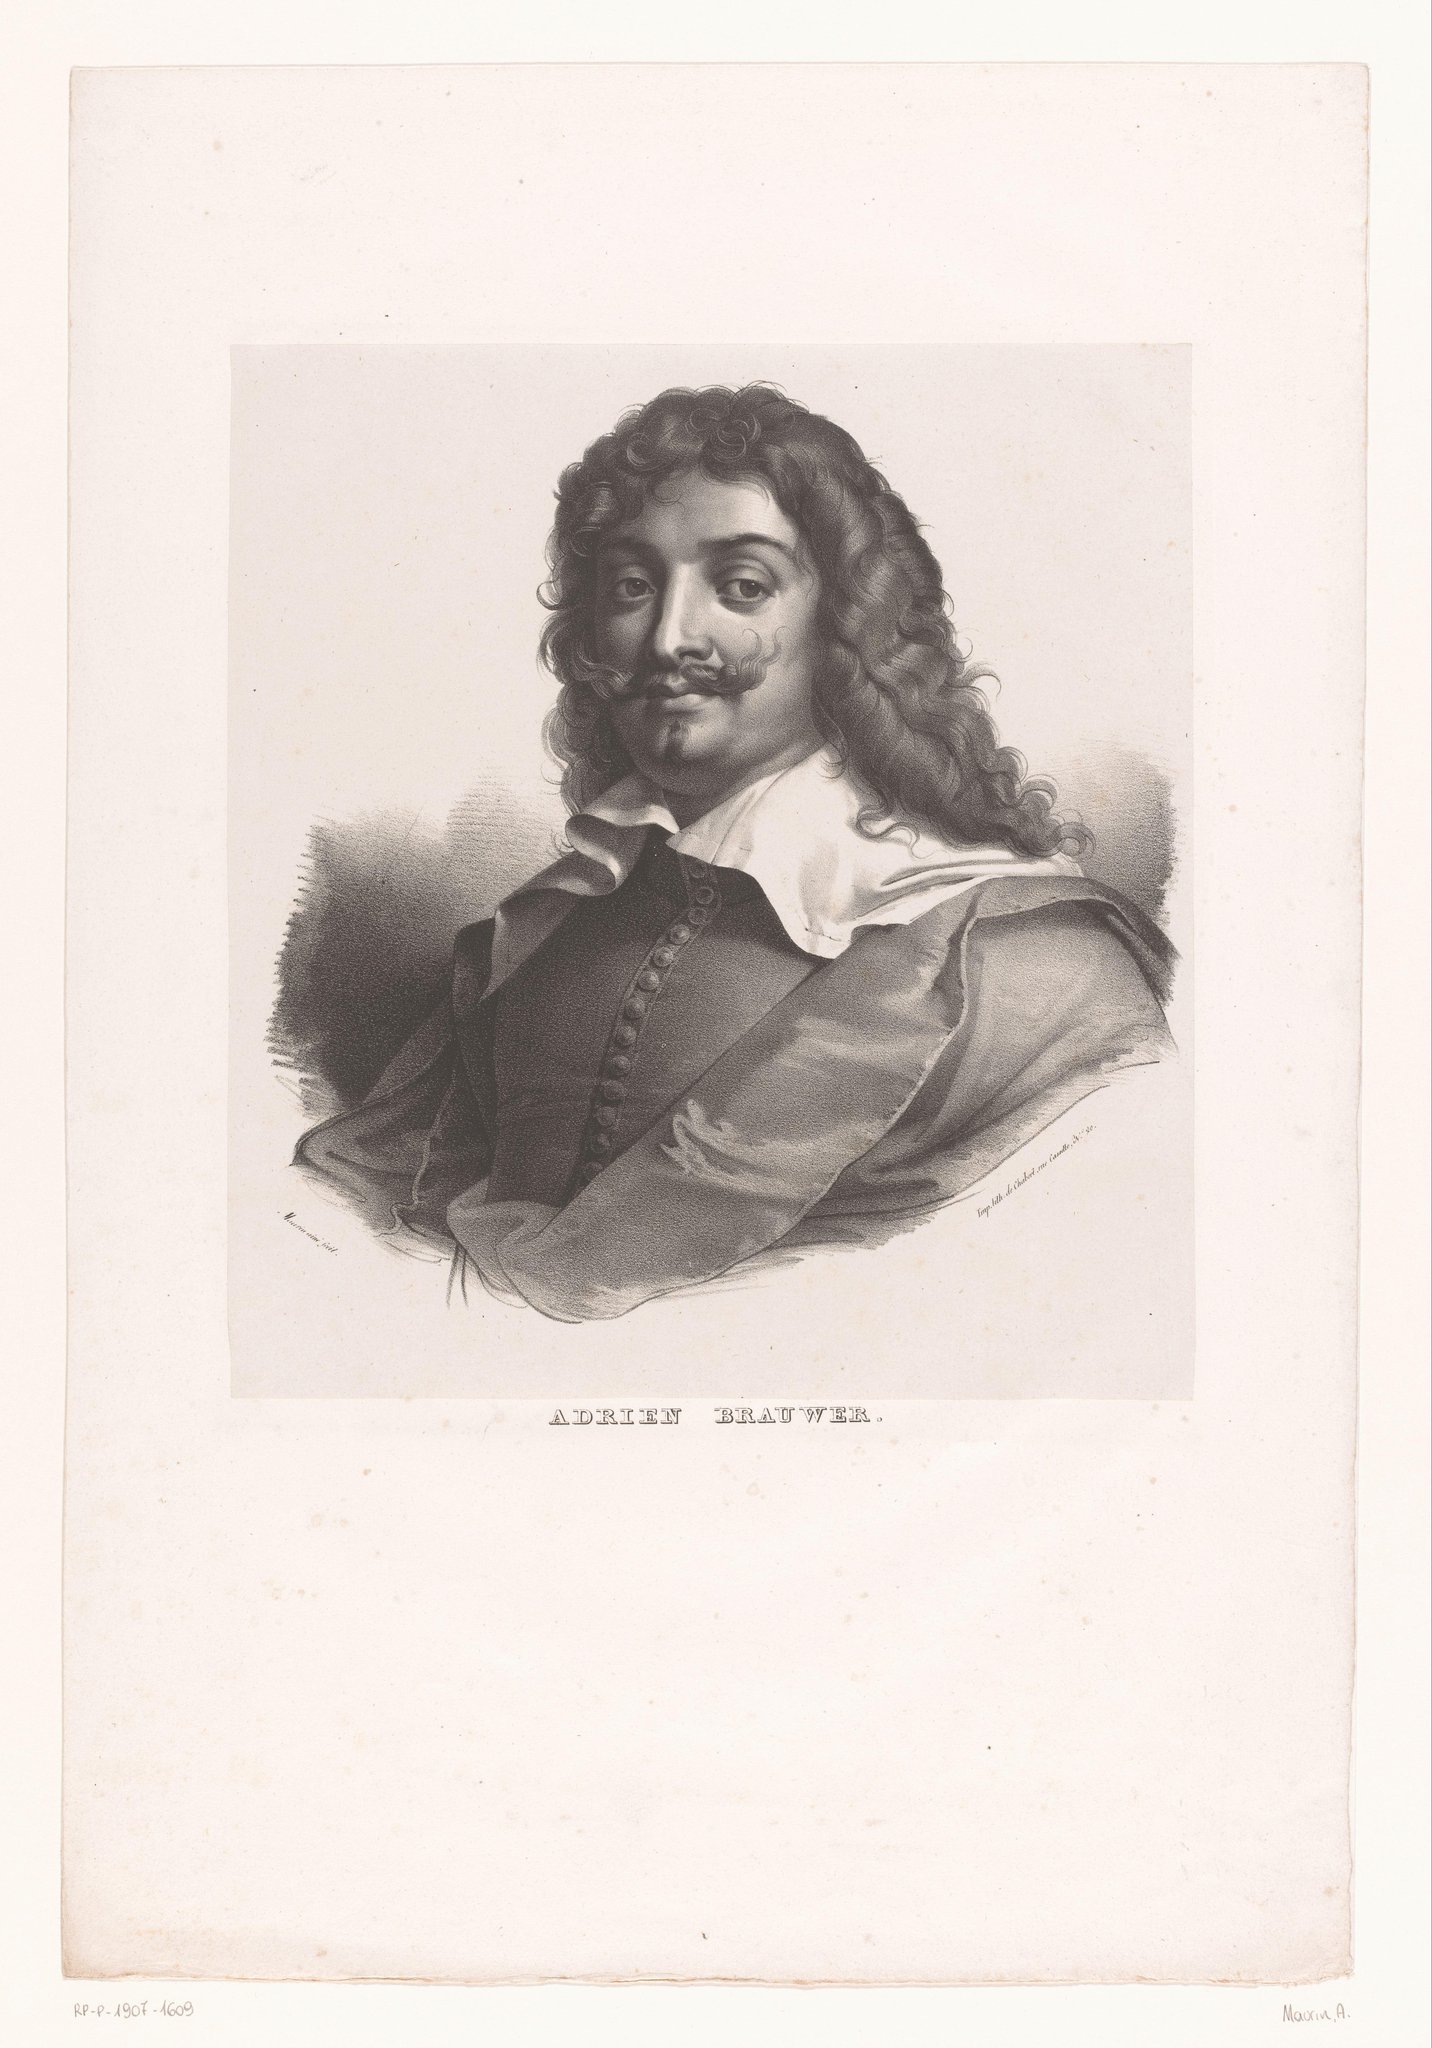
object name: print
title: Adrien Brauwer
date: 1827-1854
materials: paper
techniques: lithograph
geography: paris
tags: antwerp, painter, draughtsman, adriaen brouwer, historical persons, portrait, self-portrait of painter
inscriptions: collector's mark: Lugt 2228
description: Prent ook gebruikt in: Chabert, Jean Claude. Galerie des peintres ou collection de portraits des peintres les plus célèbres de toutes les écoles. Accompagnée d'une notice sur chacun d'eux, et de copies de dessins originaux / Galerie des peintres ou collection de portraits des peintres les plus célèbres de toutes les écoles. Accompagnée de leur notice historique, de leurs dessins et d'un discours sur les arts. Parijs: Jean Claude Chabert, s.a. [1822-1834]. De samenstelling van tegenwoordig bekende en al dan niet gebonden exemplaren van deze uitgave verschillen. Dit omdat de prenten en bijhorende stukken tekst op inschrijving en waarschijnlijk ook los verkrijgbaar waren.